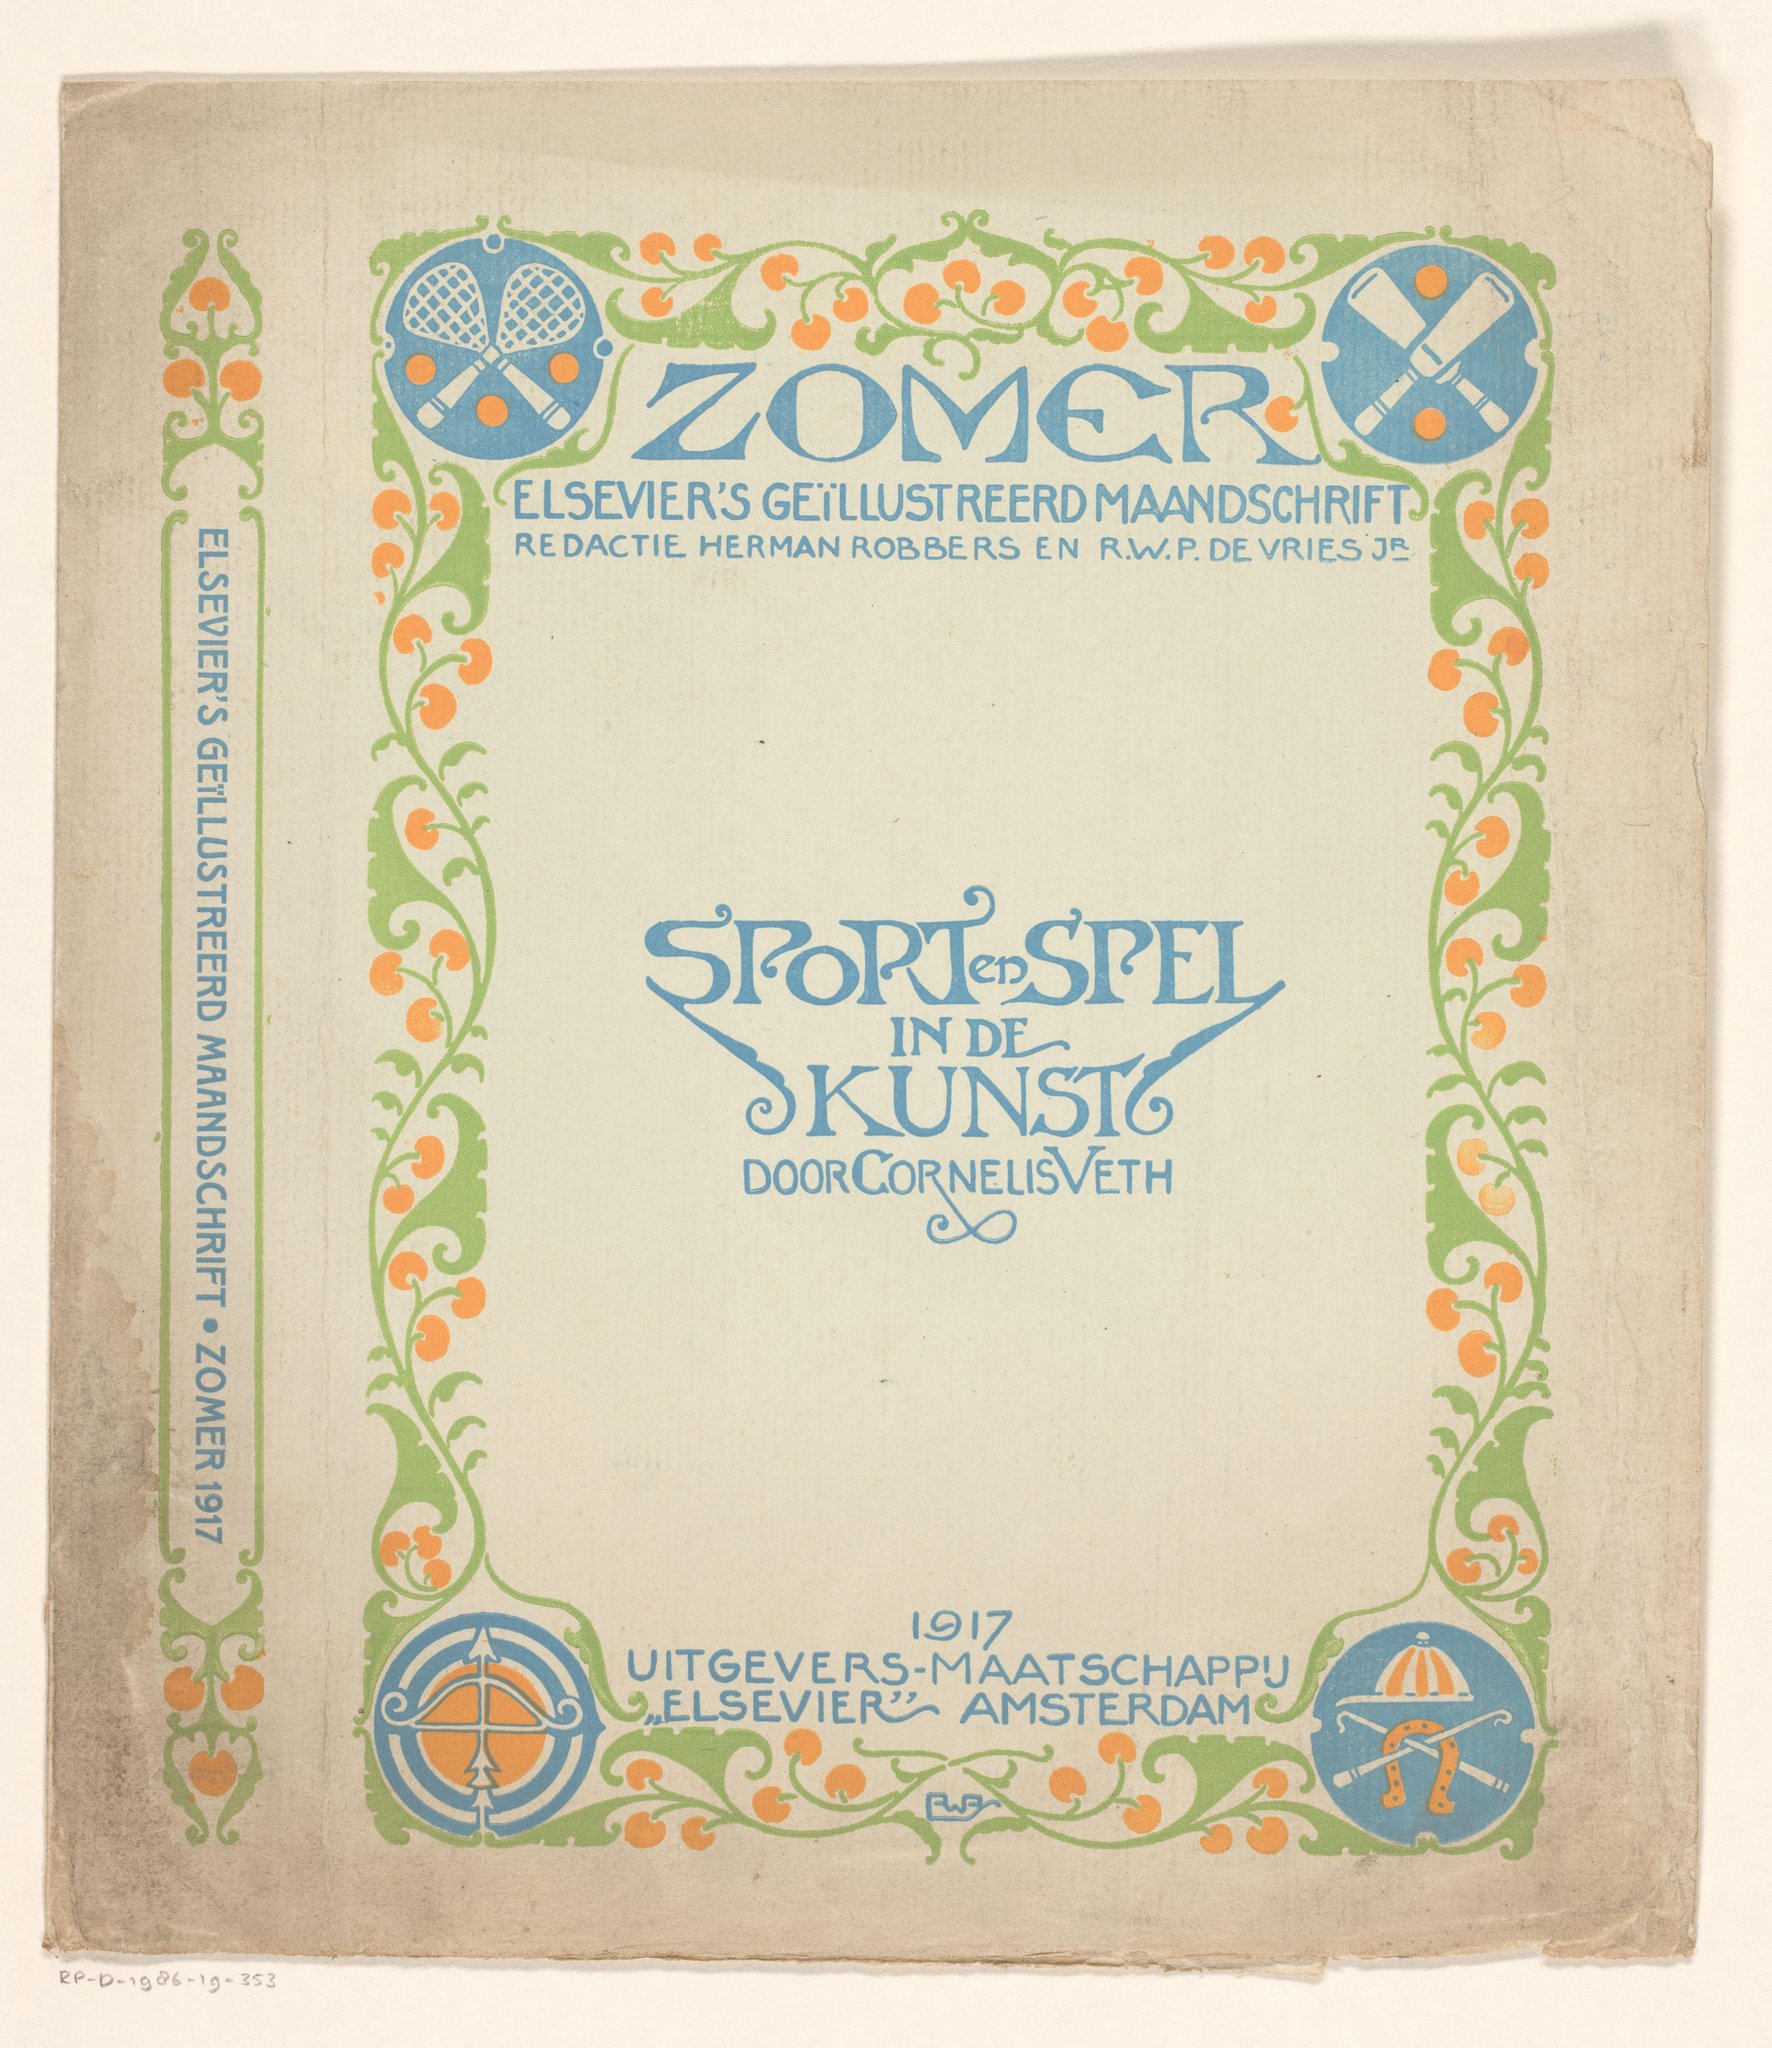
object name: photomechanical print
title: Omslag van: Cornelis Veth, Sport en spel in de kunst (Zomer), 1917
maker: reinier willem petrus de vries (1874-1953)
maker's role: draughtsman, print maker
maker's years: 1874-1953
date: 1917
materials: paper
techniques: printing block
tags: horseshoe, foliage, tendrils, branches ~ ornament, ball games in which ball is hit with racket (or hand)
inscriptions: collector's mark: ‘R:MVS.’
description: Ontwerp met een rechthoekig kader met bladornamenten en in de vier hoeken ronde vignetten met spelattributen, waaronder rackets, bats, ballen en een hoefijzer.